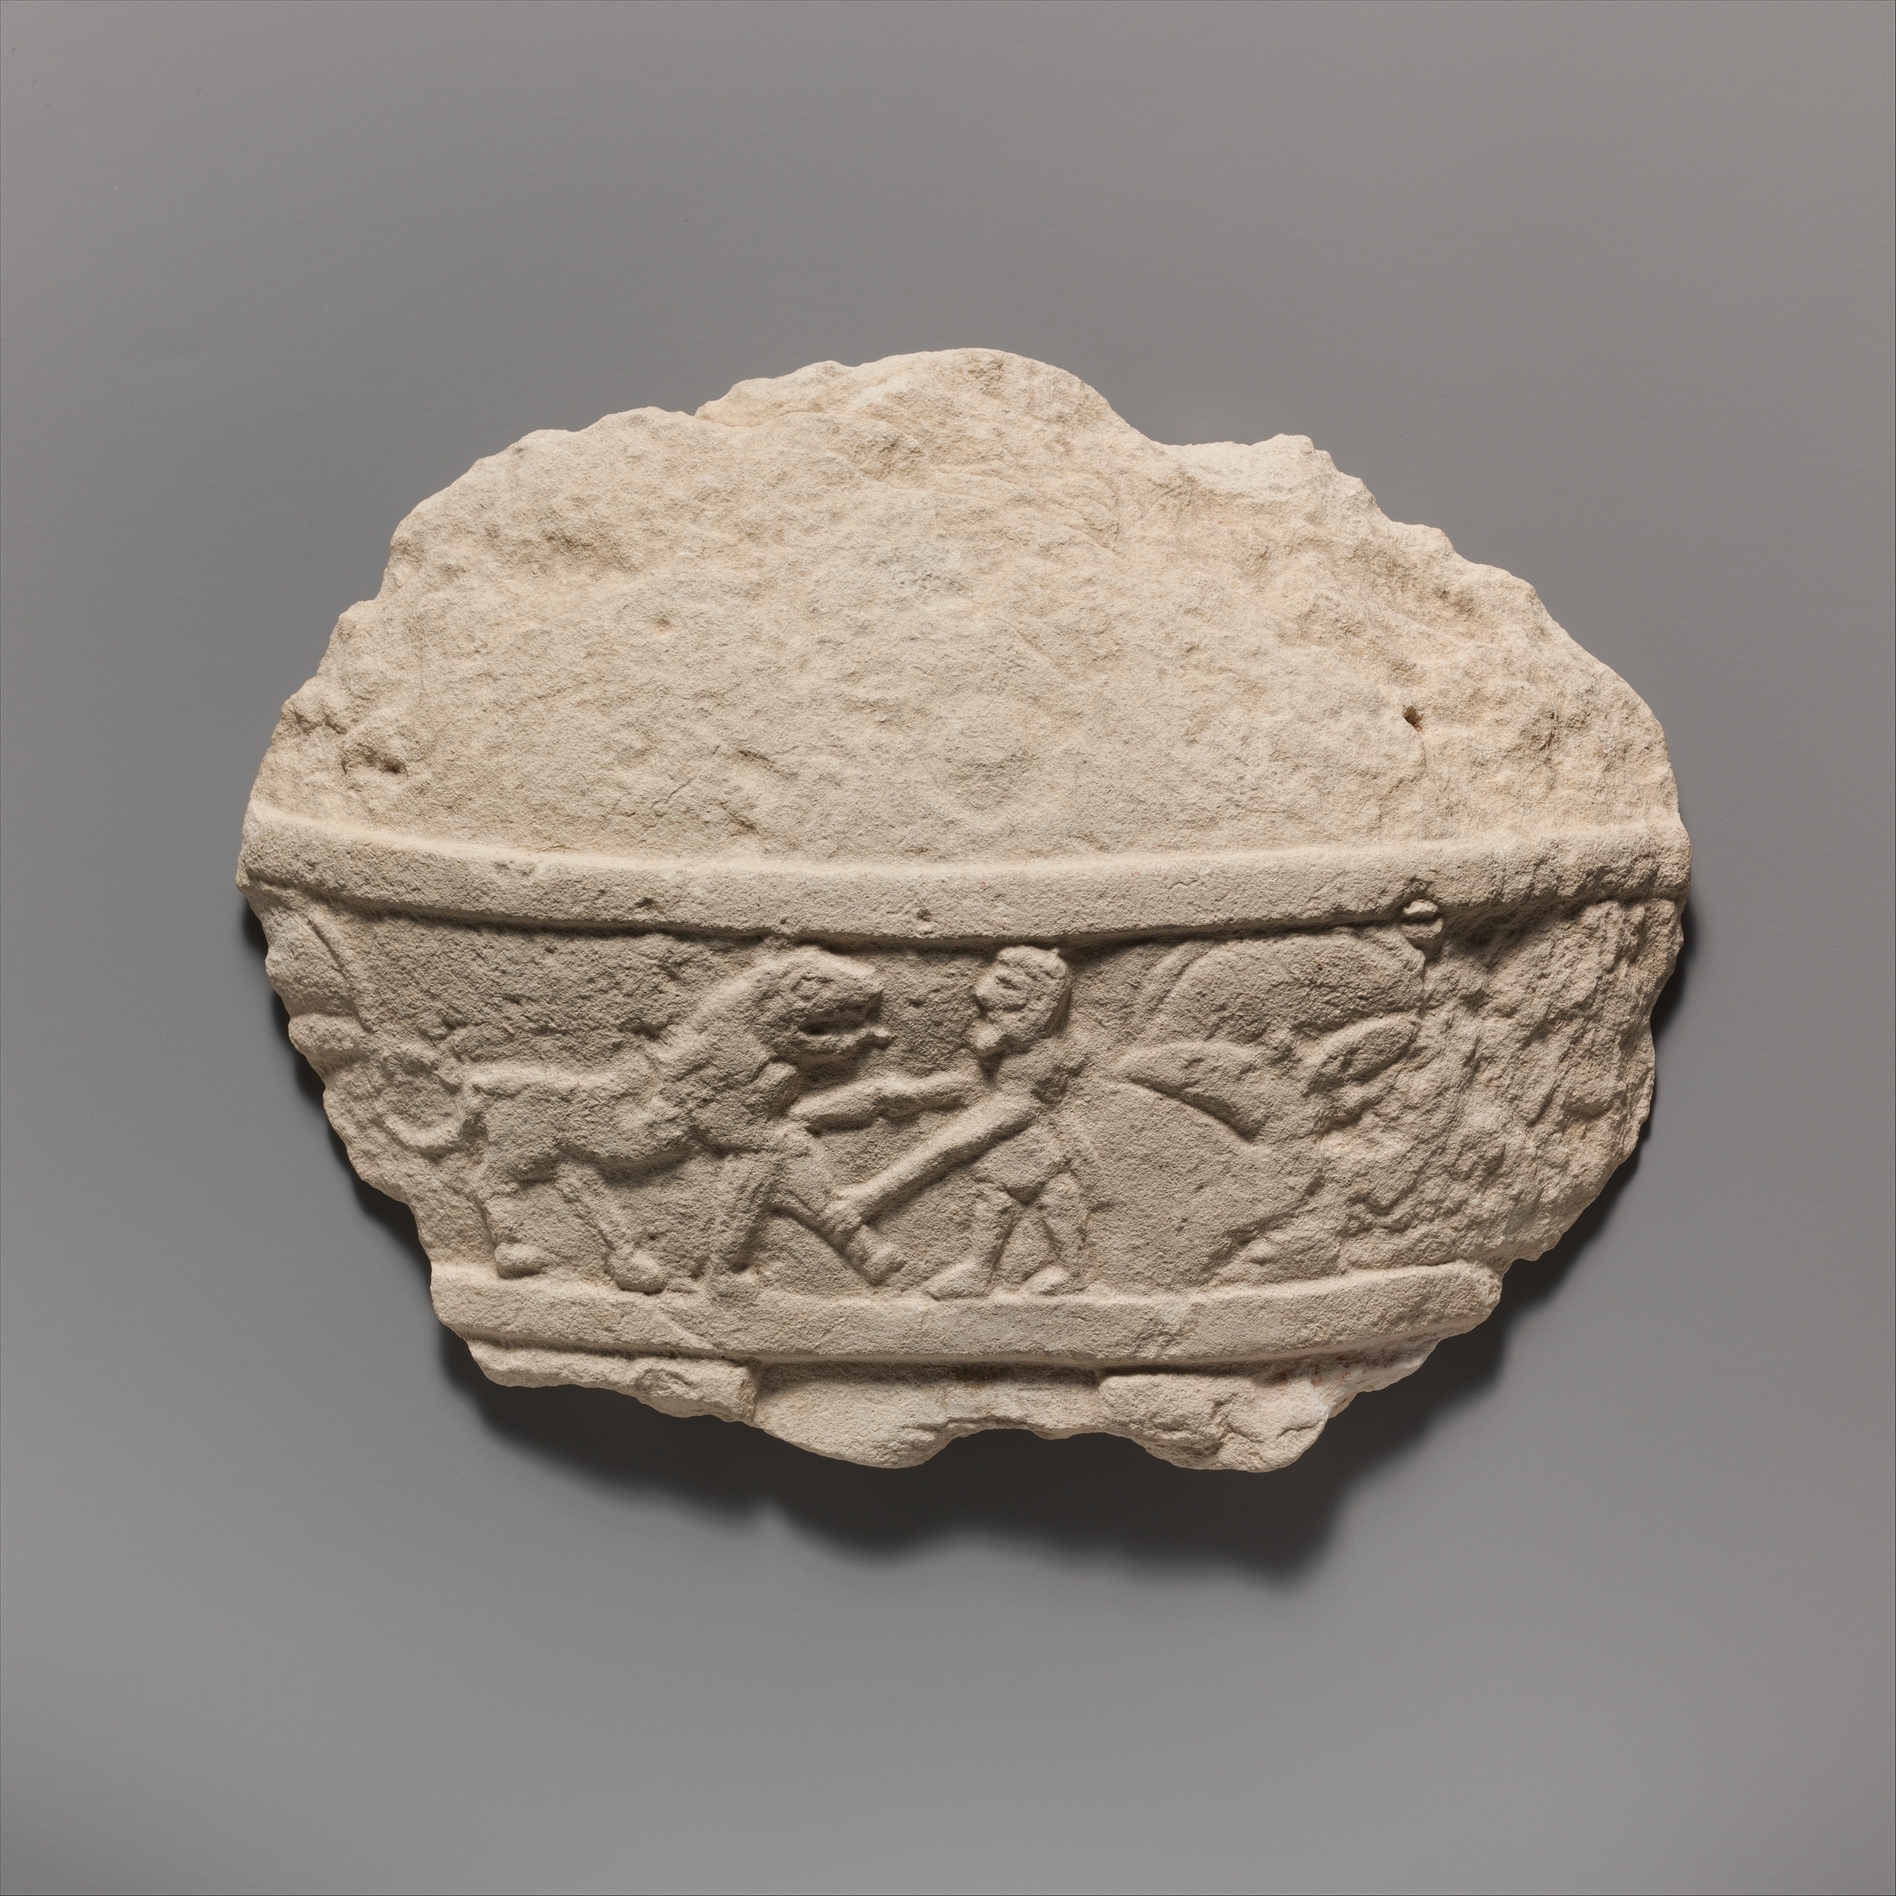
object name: statue of a male figure, fragment of belt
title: Fragment of a limestone statue of a male votary (worshipper)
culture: cypriot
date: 600-551 BCE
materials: limestone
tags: lions,herakles